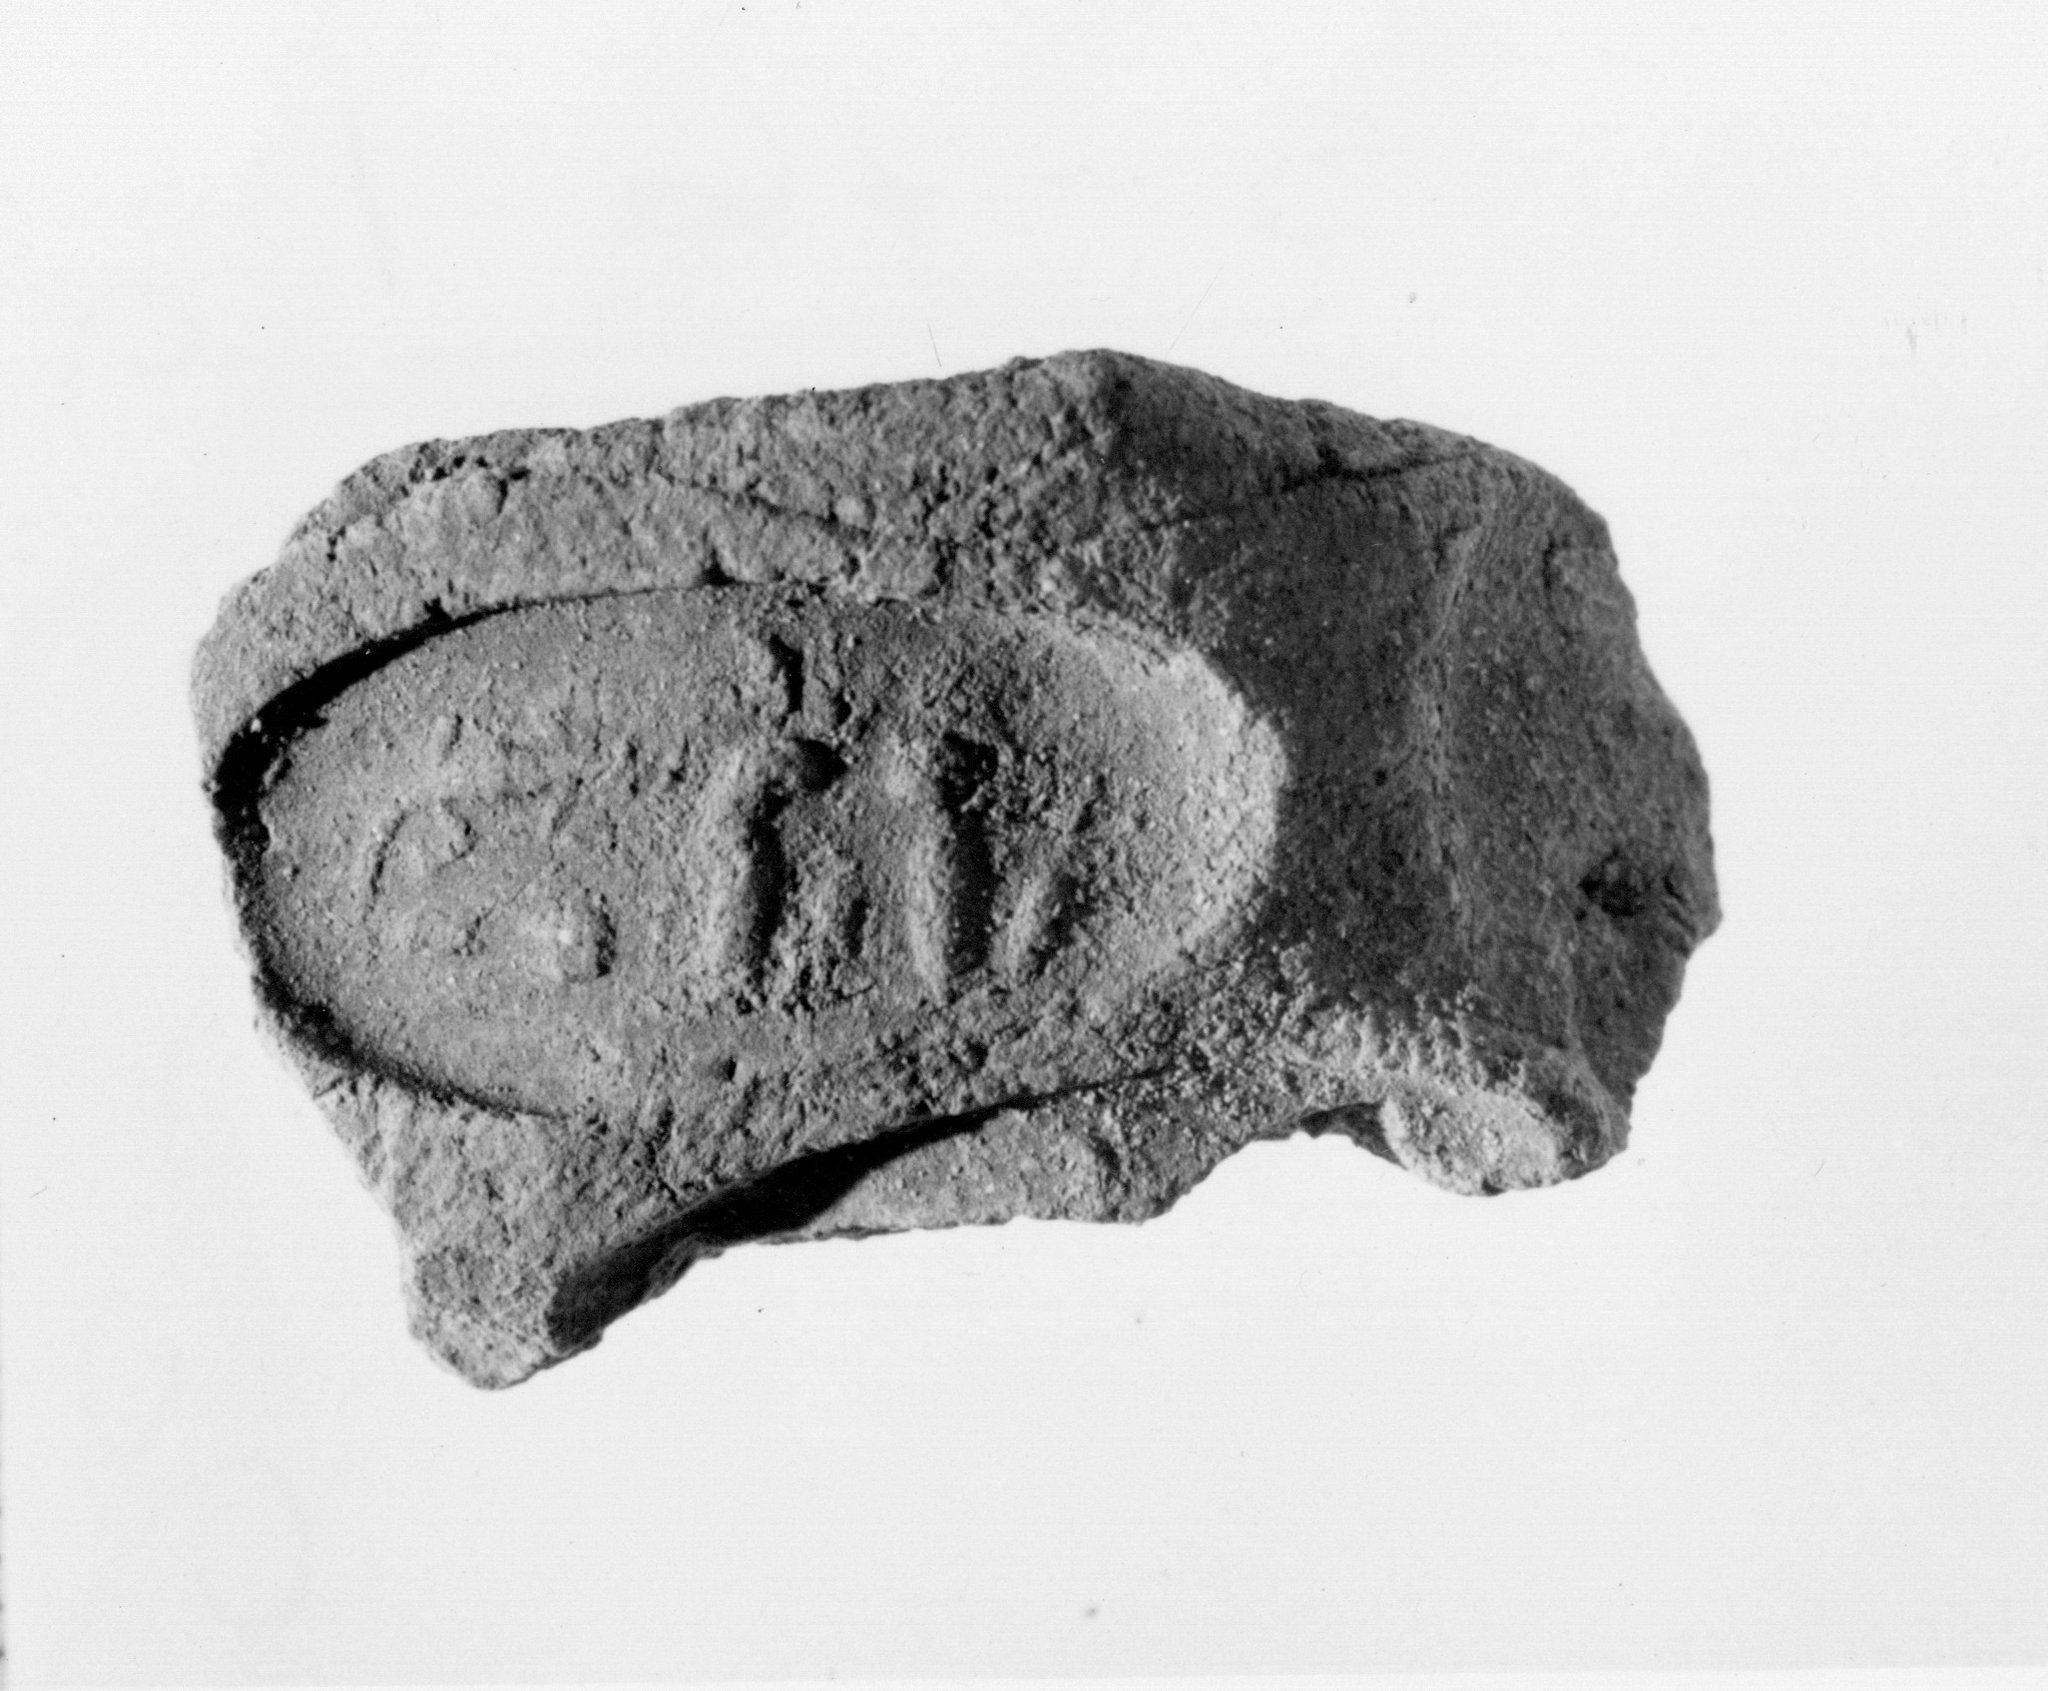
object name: sealing, nebmaatre, amenhotep iii,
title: Document Sealing With the Throne Name of Amenhotep III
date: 1390-1352 BCE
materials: mud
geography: egypt